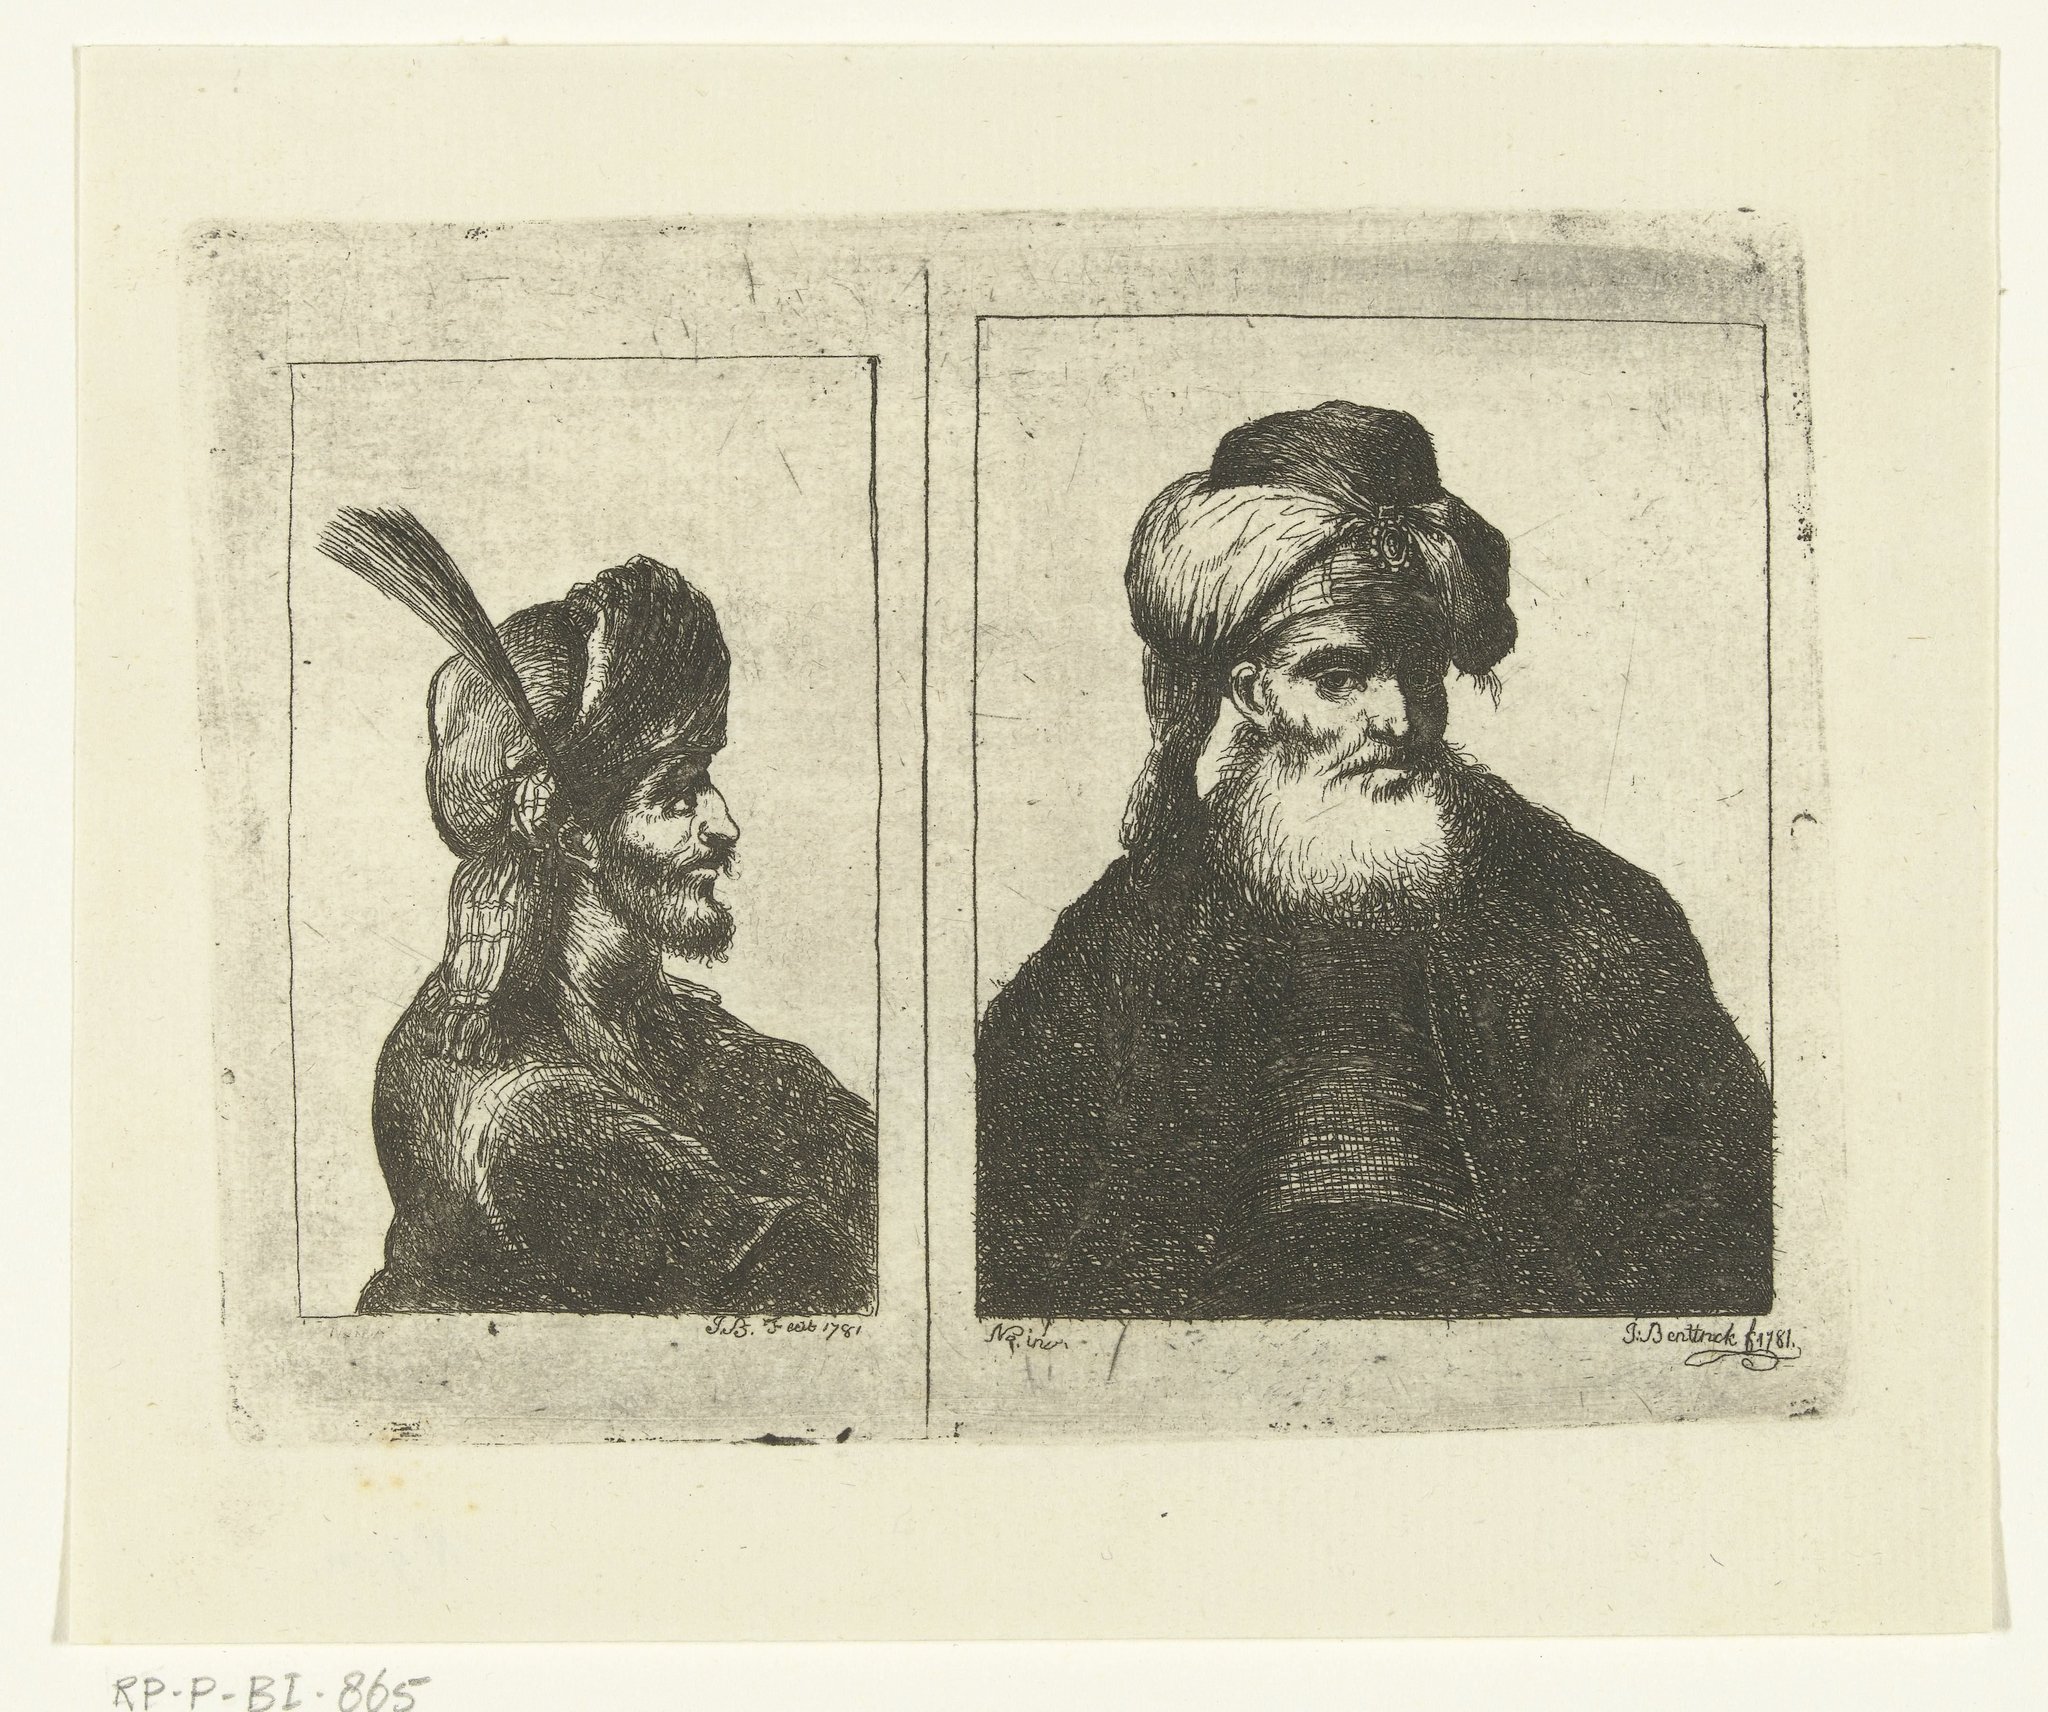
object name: print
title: Twee bustes van mannen met tulband en baard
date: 1781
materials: paper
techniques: etching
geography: netherlands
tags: head-gear: turban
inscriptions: collector's mark: Lugt 2228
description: Twee bustes van mannen met tulband en baard, mogelijk Egyptenaren. De bustes zijn elk in een kader geplaatst welke onderling verschillen van formaat.